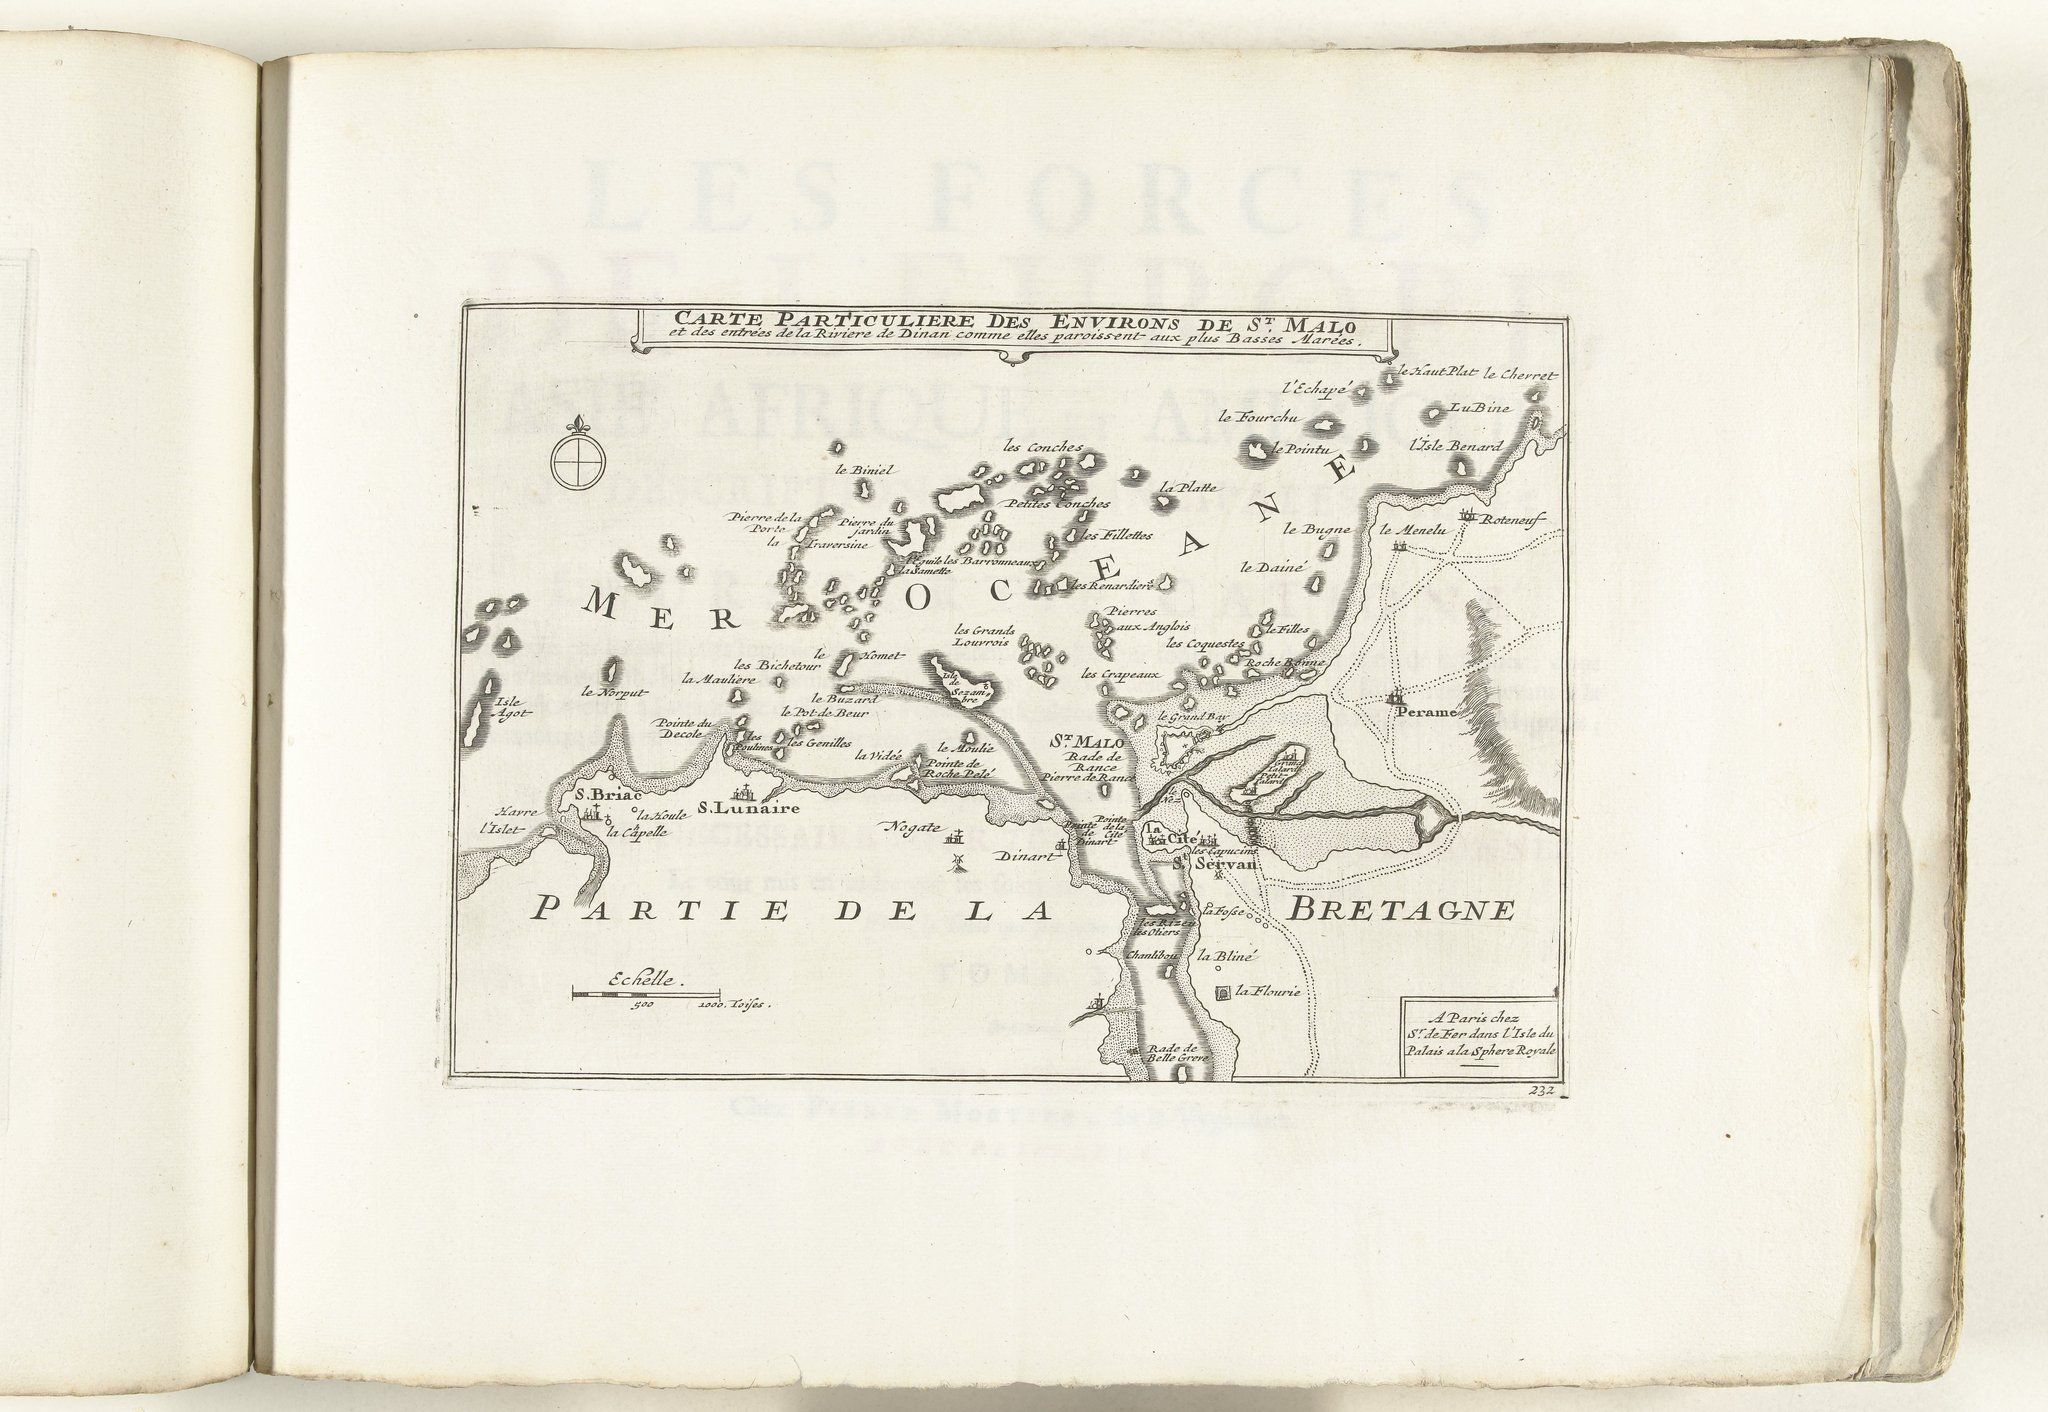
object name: print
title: Kaart van Saint-Malo en omgeving, ca. 1702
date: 1702-1703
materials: paper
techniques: engraving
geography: amsterdam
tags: maps of separate countries or regions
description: Kaart van de Franse stad Saint-Malo en omgeving. Plaat nr. 232 in het prentwerk bestaande in totaal uit 276 genummerde platen van vermaarde sterke steden en vestingen in het kader van de Spaanse Successieoorlog. Voor het merendeel zijn deze platen gekopieerd naar de anonieme Franse platen: in Les forces de l'Europe en in: Le theatre de la guerre, dans les Pays-Bas, beide oorspronkelijk uitgegeven door Nicolas de Fer te Parijs (1693-1697) in het kader van de Negenjarige Oorlog. Titel en opschriften in de plaat in het Frans.